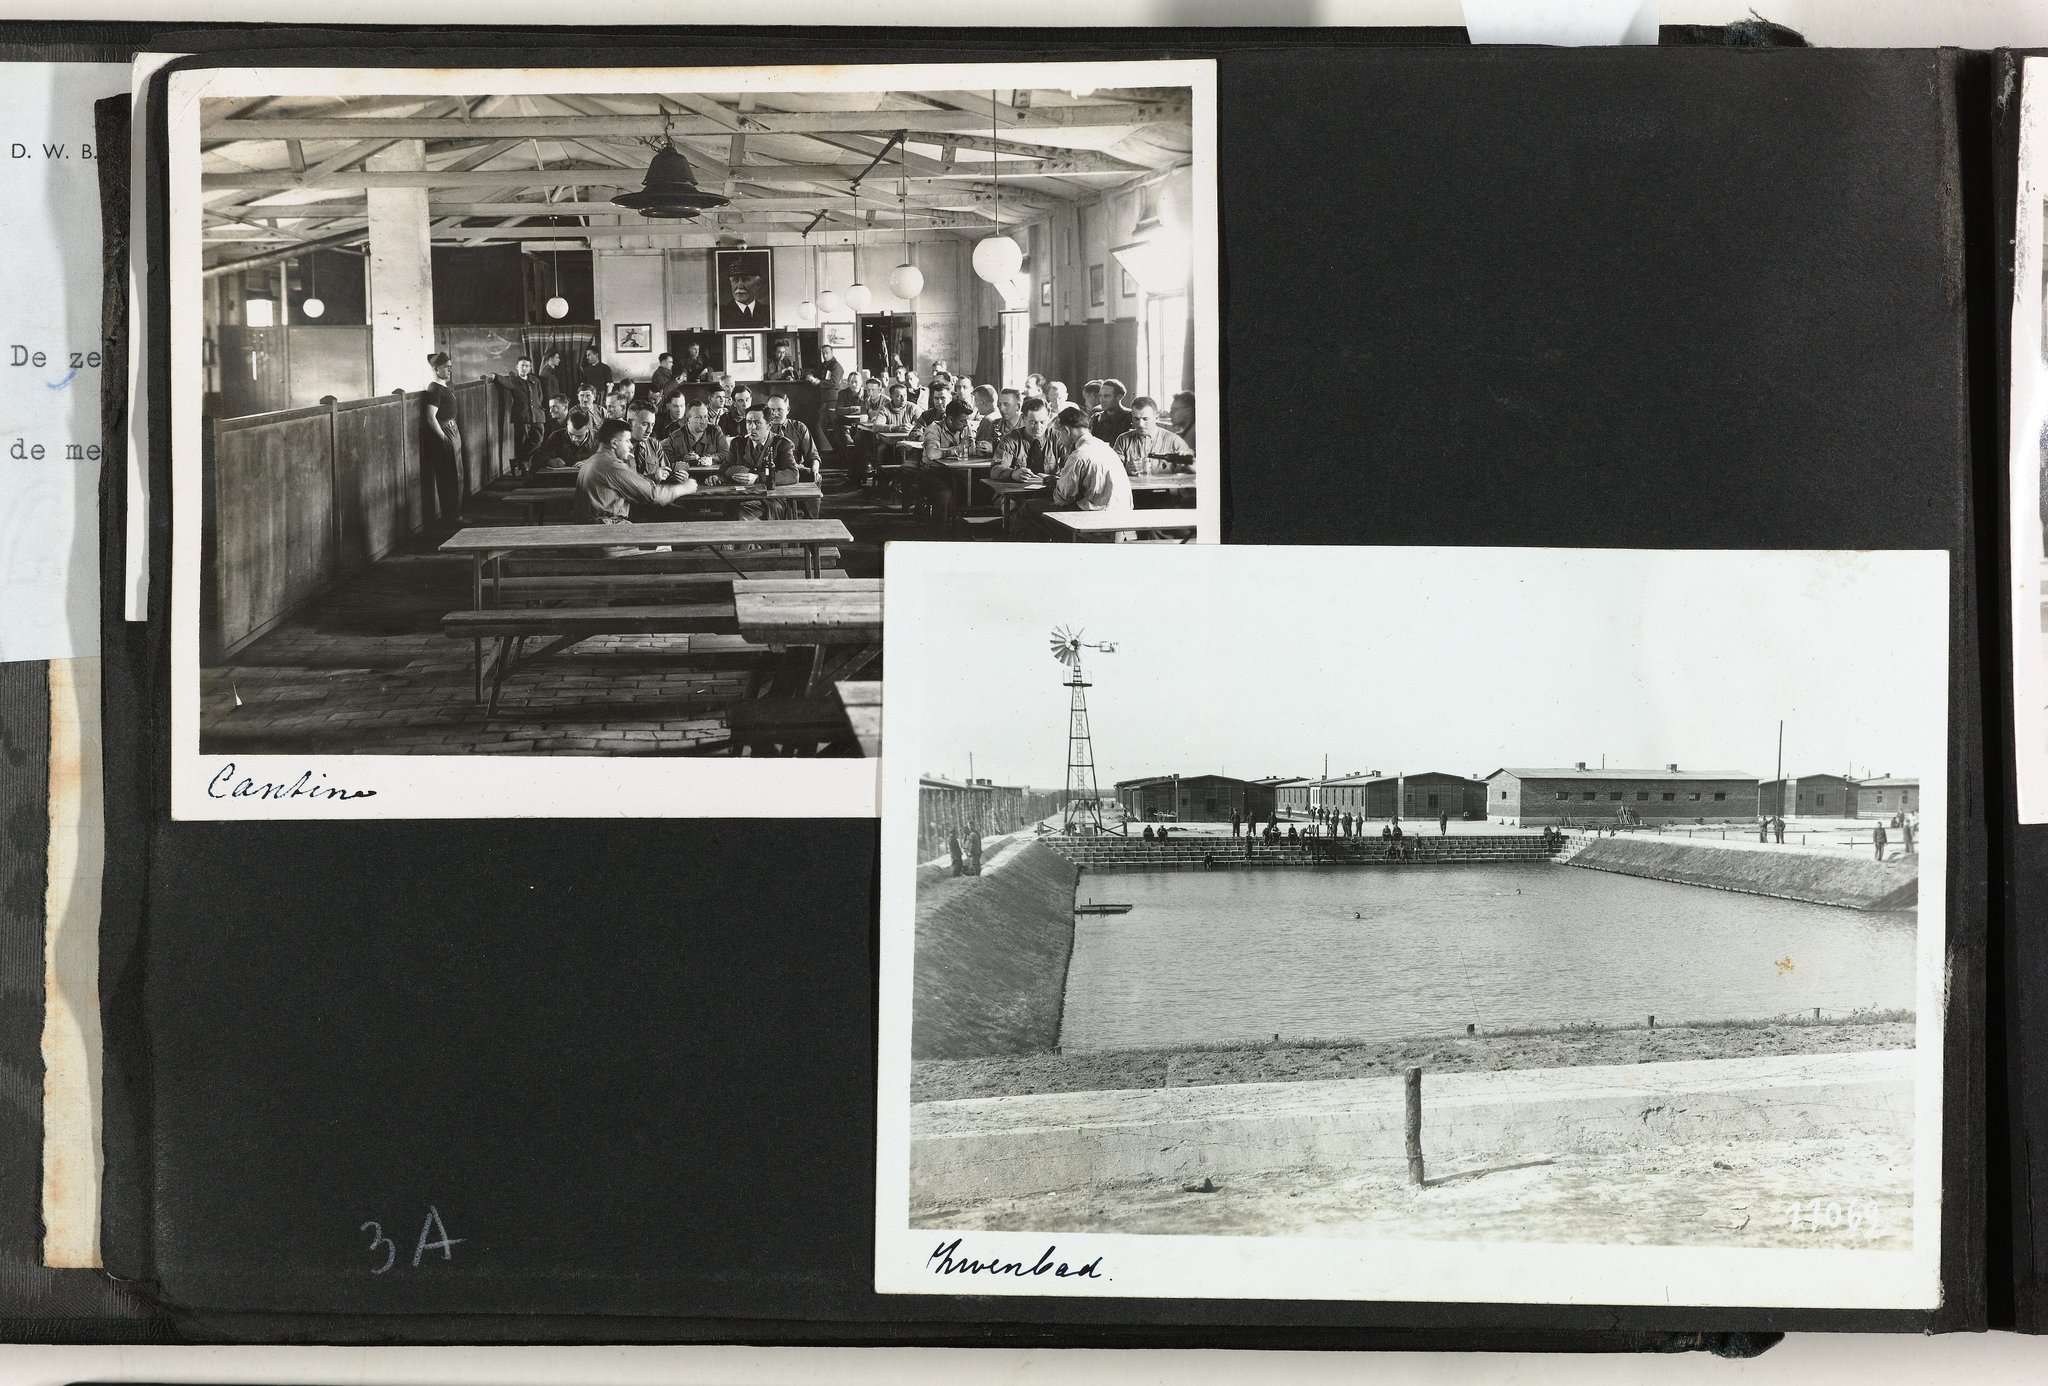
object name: album leaf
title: Cantine / Zwembad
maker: dick w.b. van maarseveen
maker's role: fotograaf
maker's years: 1905-1990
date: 1943-1945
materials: cardboard, photographic support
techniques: gelatin silver print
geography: muhlberg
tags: the hague, dick w.b. van maarseveen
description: Albumblad met twee foto’s: krijgsgevangenen etend in de kantine en gezicht op de vijver als waterreservoir voor de brandweer, tevens in gebruik als zwembad. Onderdeel van een fotoalbum met foto's door Dick van Maarseveen van het krijgsgevangenenkamp Stalag IV B in Mühlberg in de periode 1943-1945.